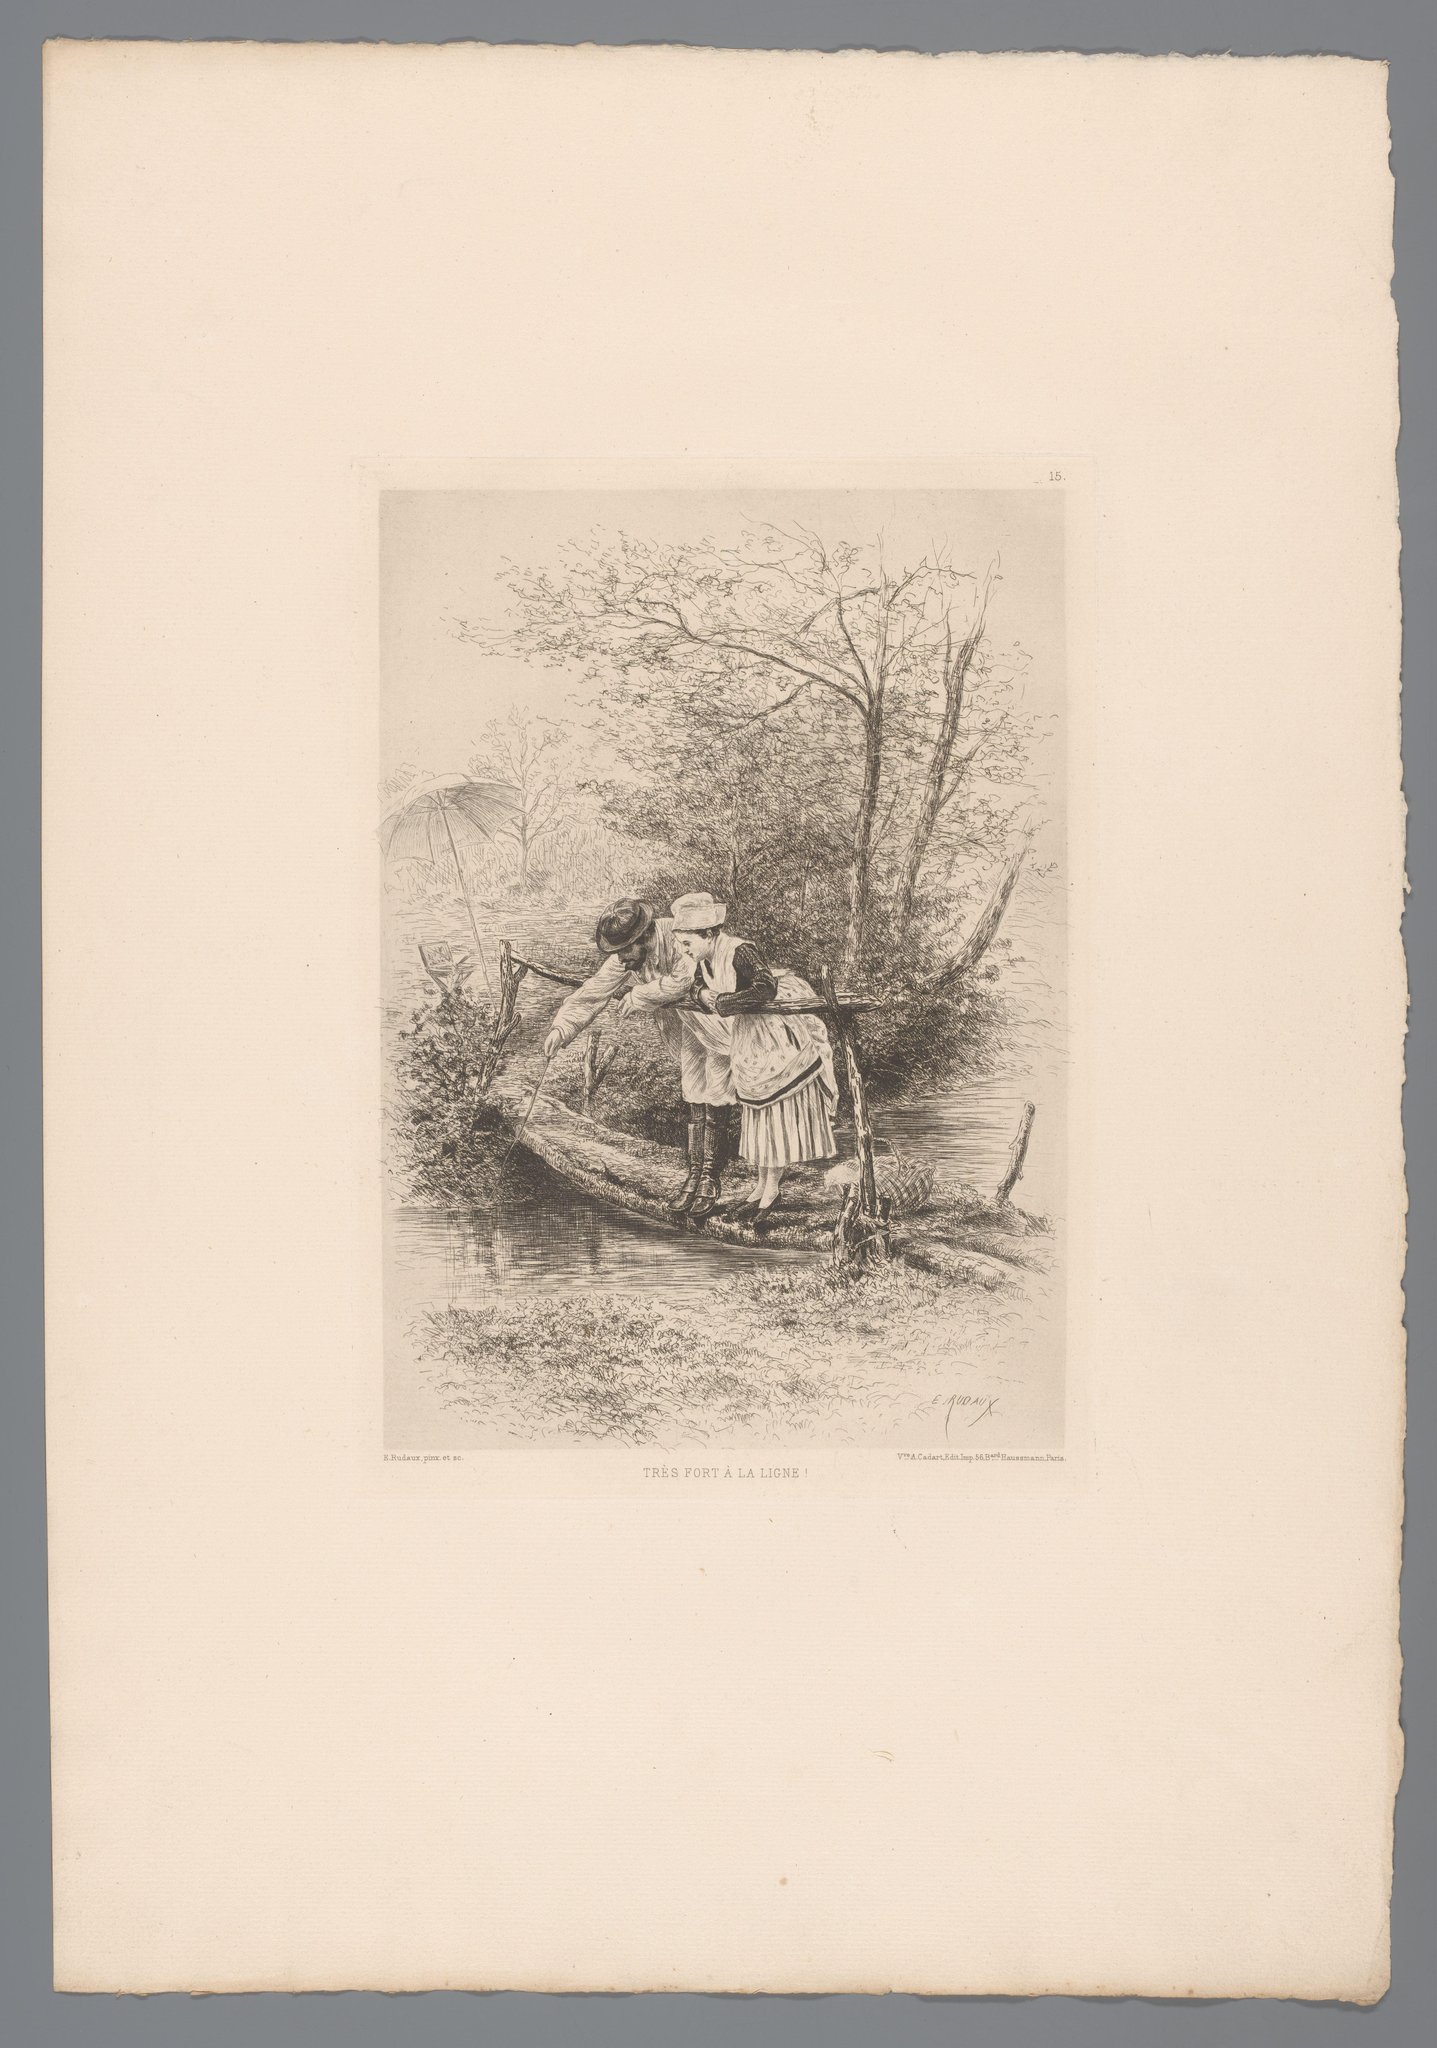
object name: print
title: Boslandschap met hengelend paar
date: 1878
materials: paper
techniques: drypoint, etching, intaglio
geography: paris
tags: forest, wood, angling, couple of lovers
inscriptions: watermark, collector's mark: ‘AFE v S’, collector's mark: Lugt 2760, collector's mark: Lugt 2228